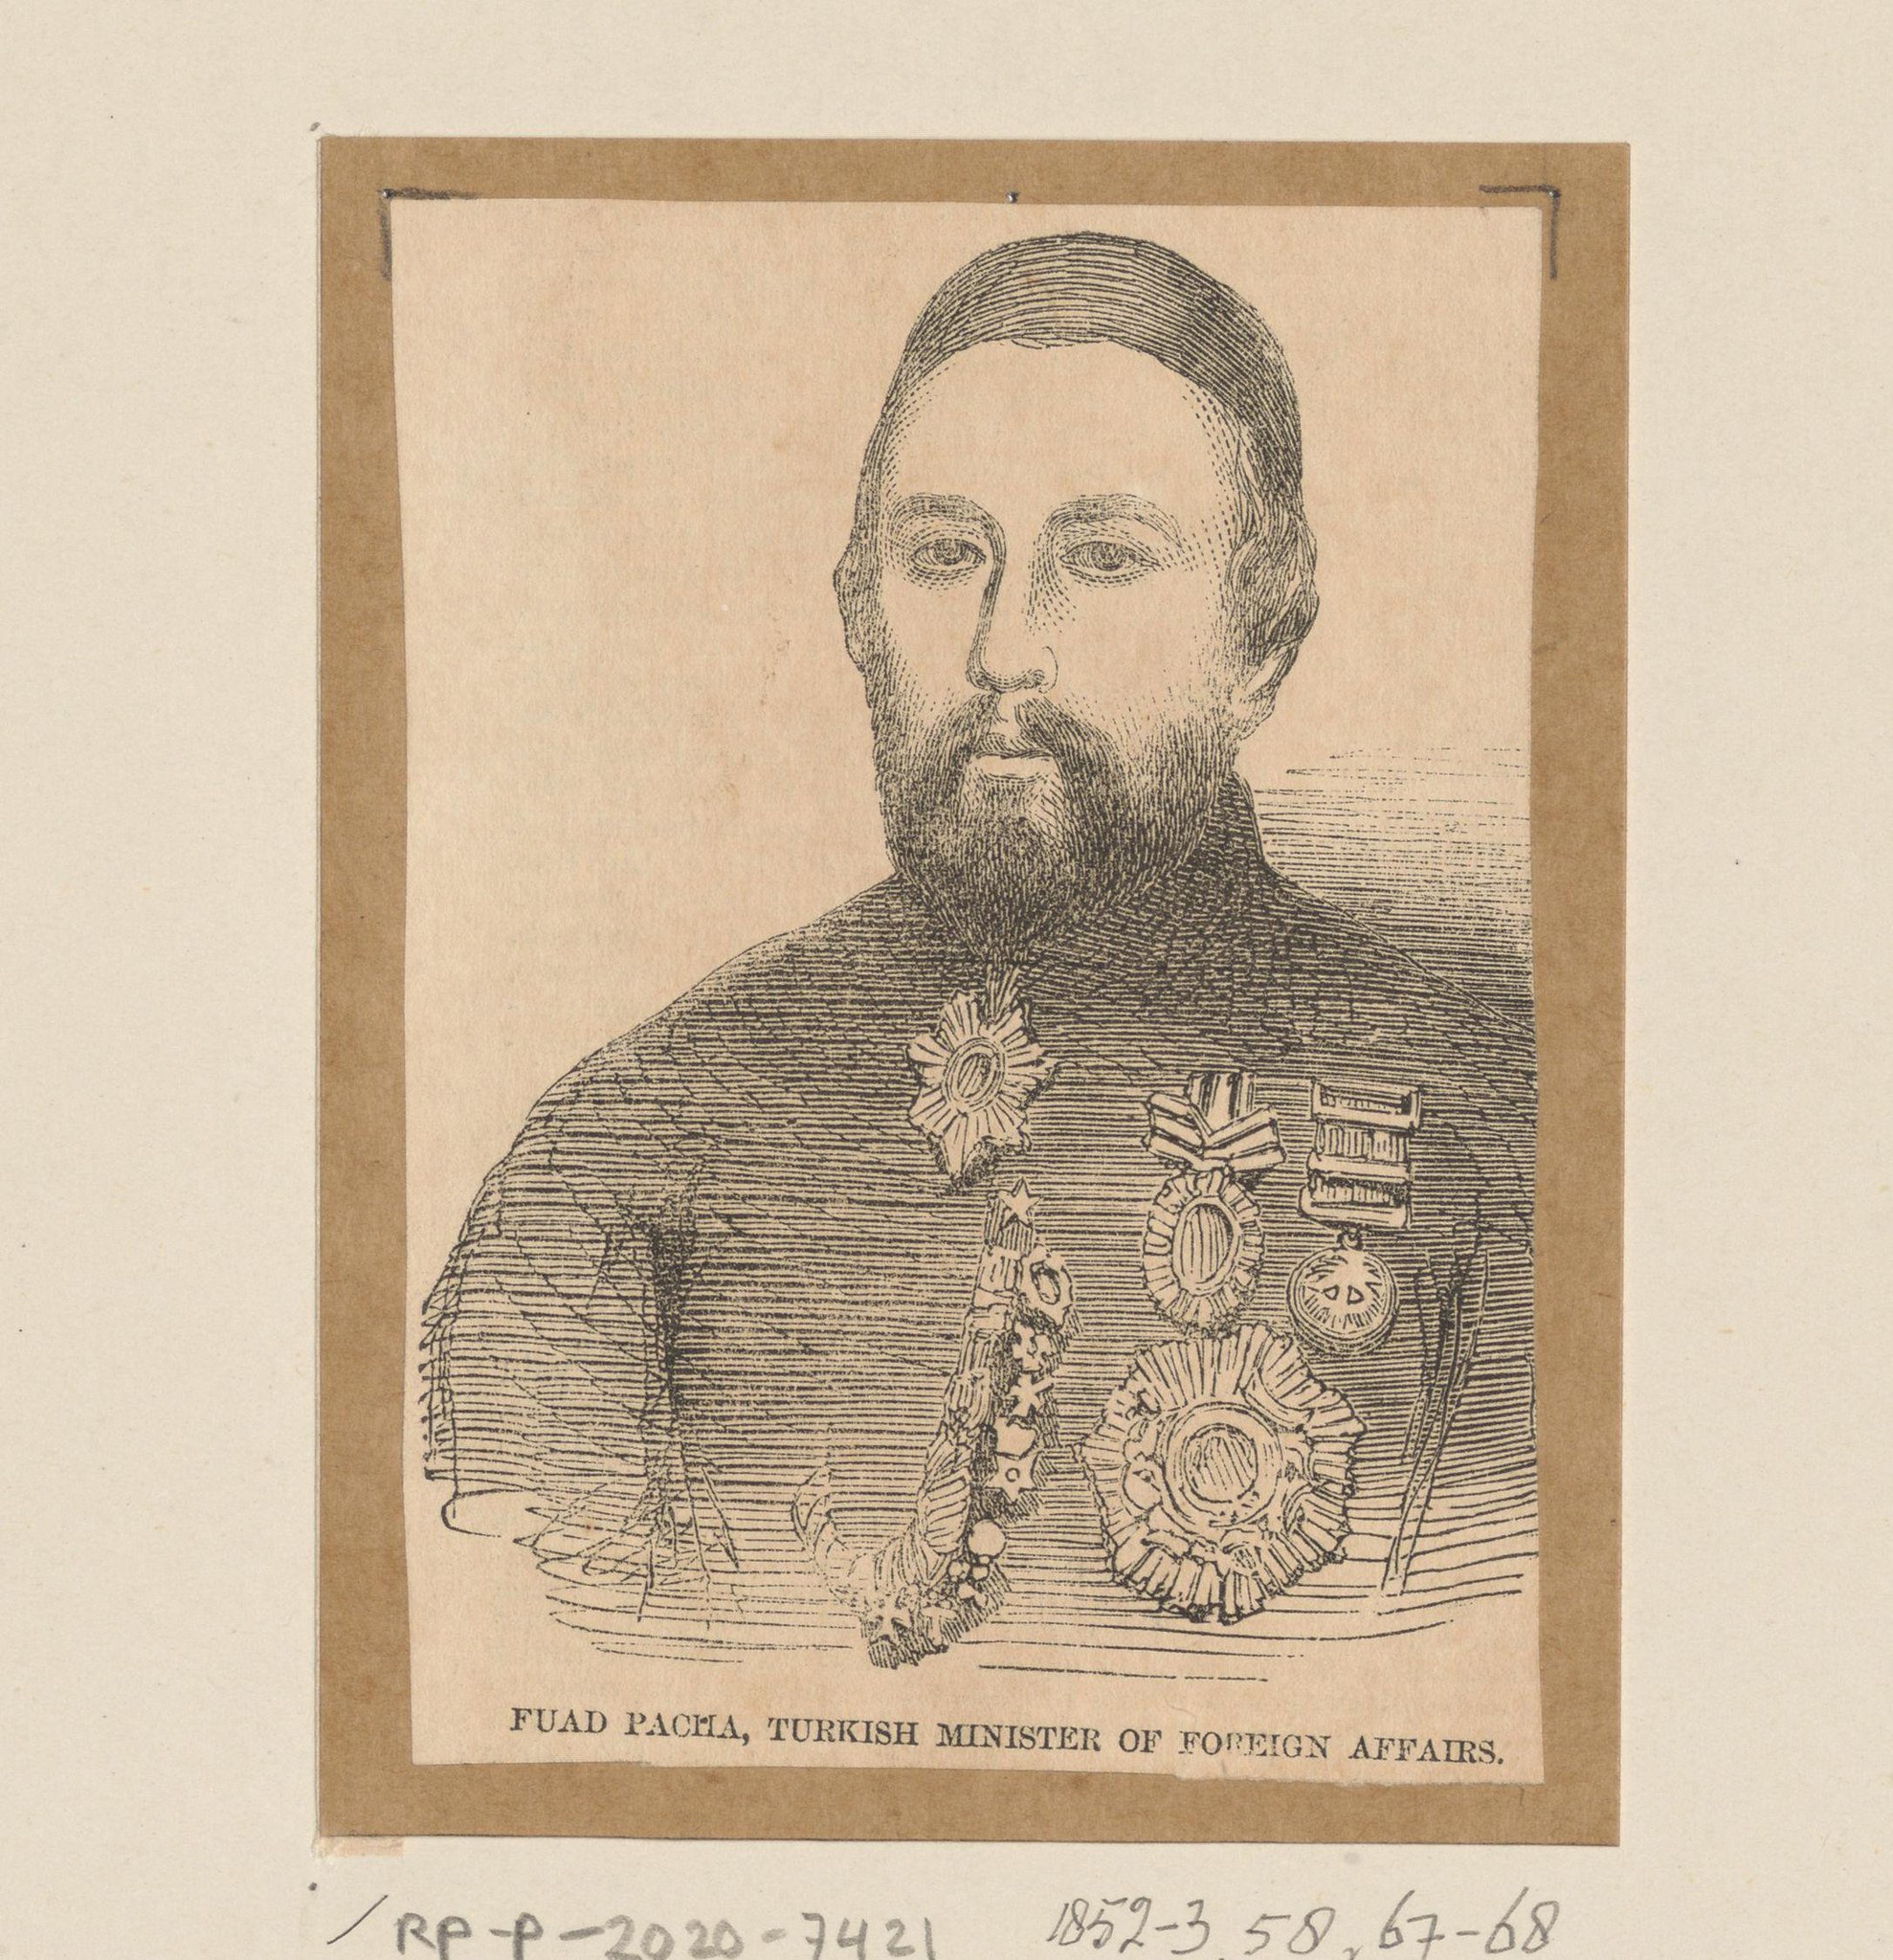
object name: print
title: Portret van Mehmed Fuad Pasja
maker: Anonymous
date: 1852-1869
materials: paper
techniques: letterpress printing, engraving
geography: england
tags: historical persons, politician, e.g. party leader, (military) uniforms